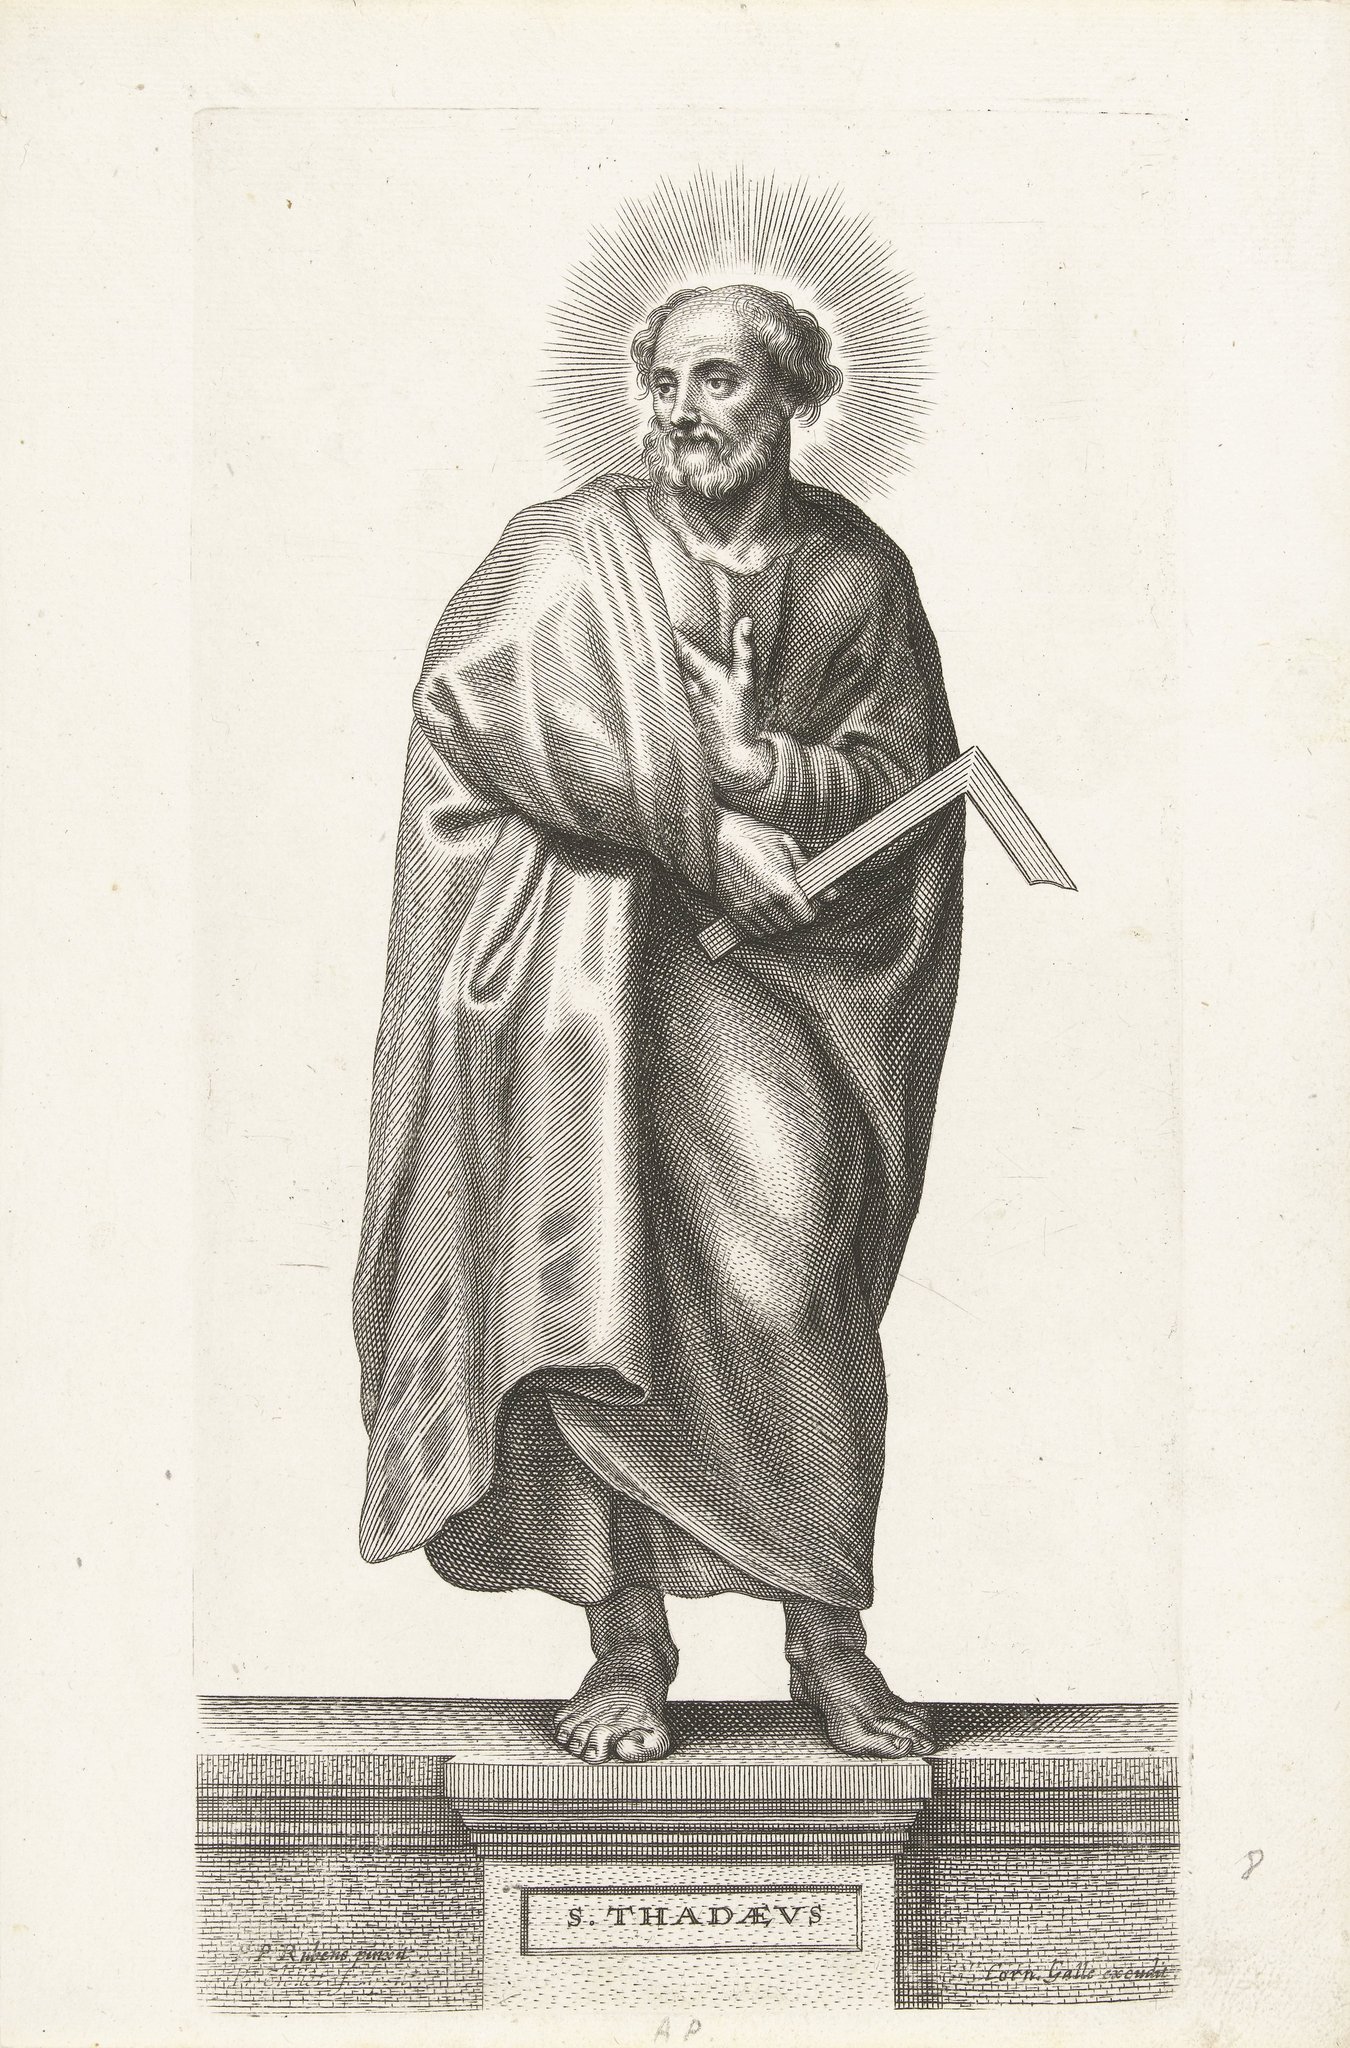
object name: print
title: SS Apostolorum Iconen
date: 1639-1670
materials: paper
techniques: engraving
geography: antwerp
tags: the apostle jude thaddaeus; possible attributes: book, club, halberd, scroll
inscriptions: collector's mark: Lugt 2760, collector's mark: Lugt 2228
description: De prent toont de Heilige Judas Taddeüs. In zijn rechterhand de tekendriehoek. De serie bestaat uit prenten gebaseerd op schilderijen van Peter Paul Rubens.